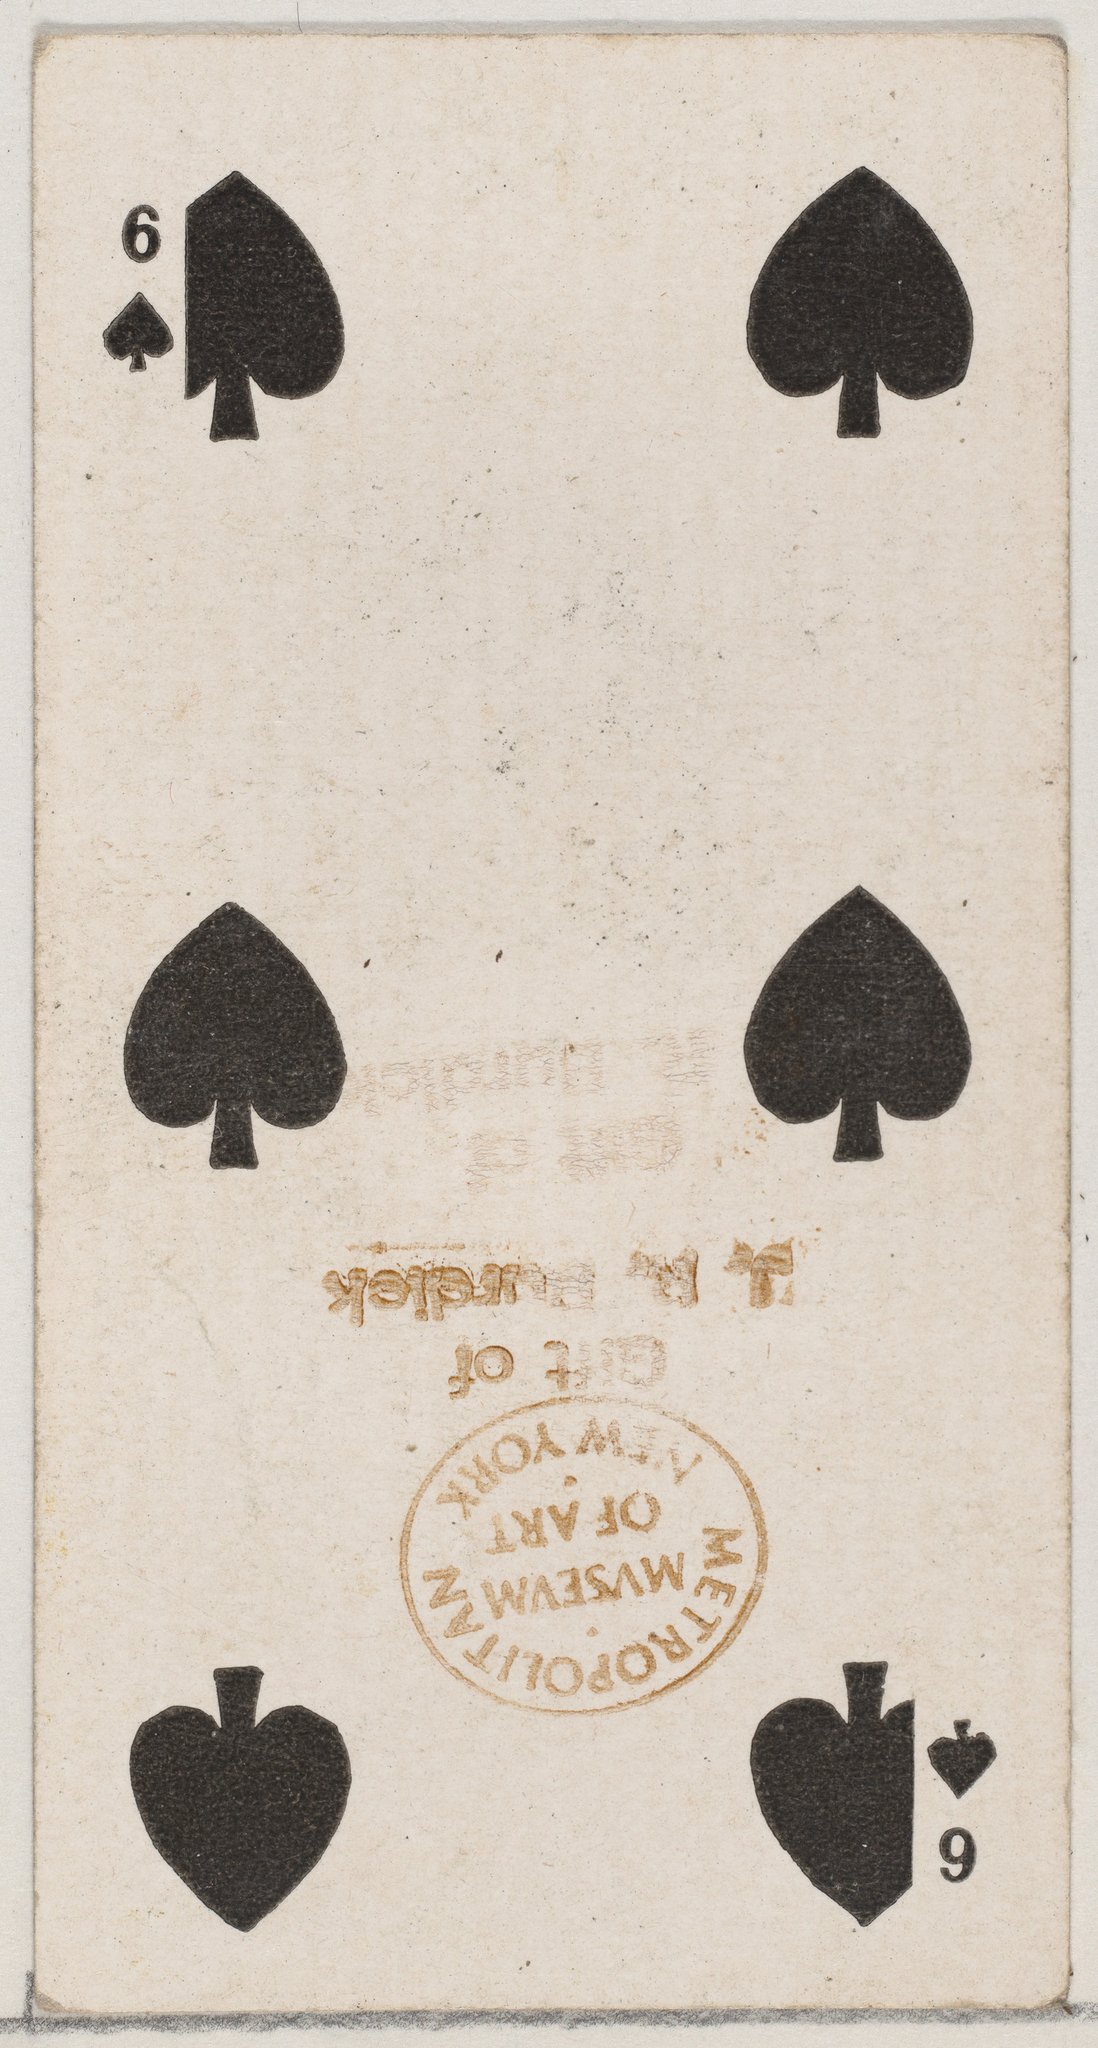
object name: print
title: Six Spades (black), from the Playing Cards series (N84) for Duke brand cigarettes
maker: w. duke, sons & co.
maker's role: publisher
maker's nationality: american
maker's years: 1870-1920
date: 1888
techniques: color lithograph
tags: playing cards